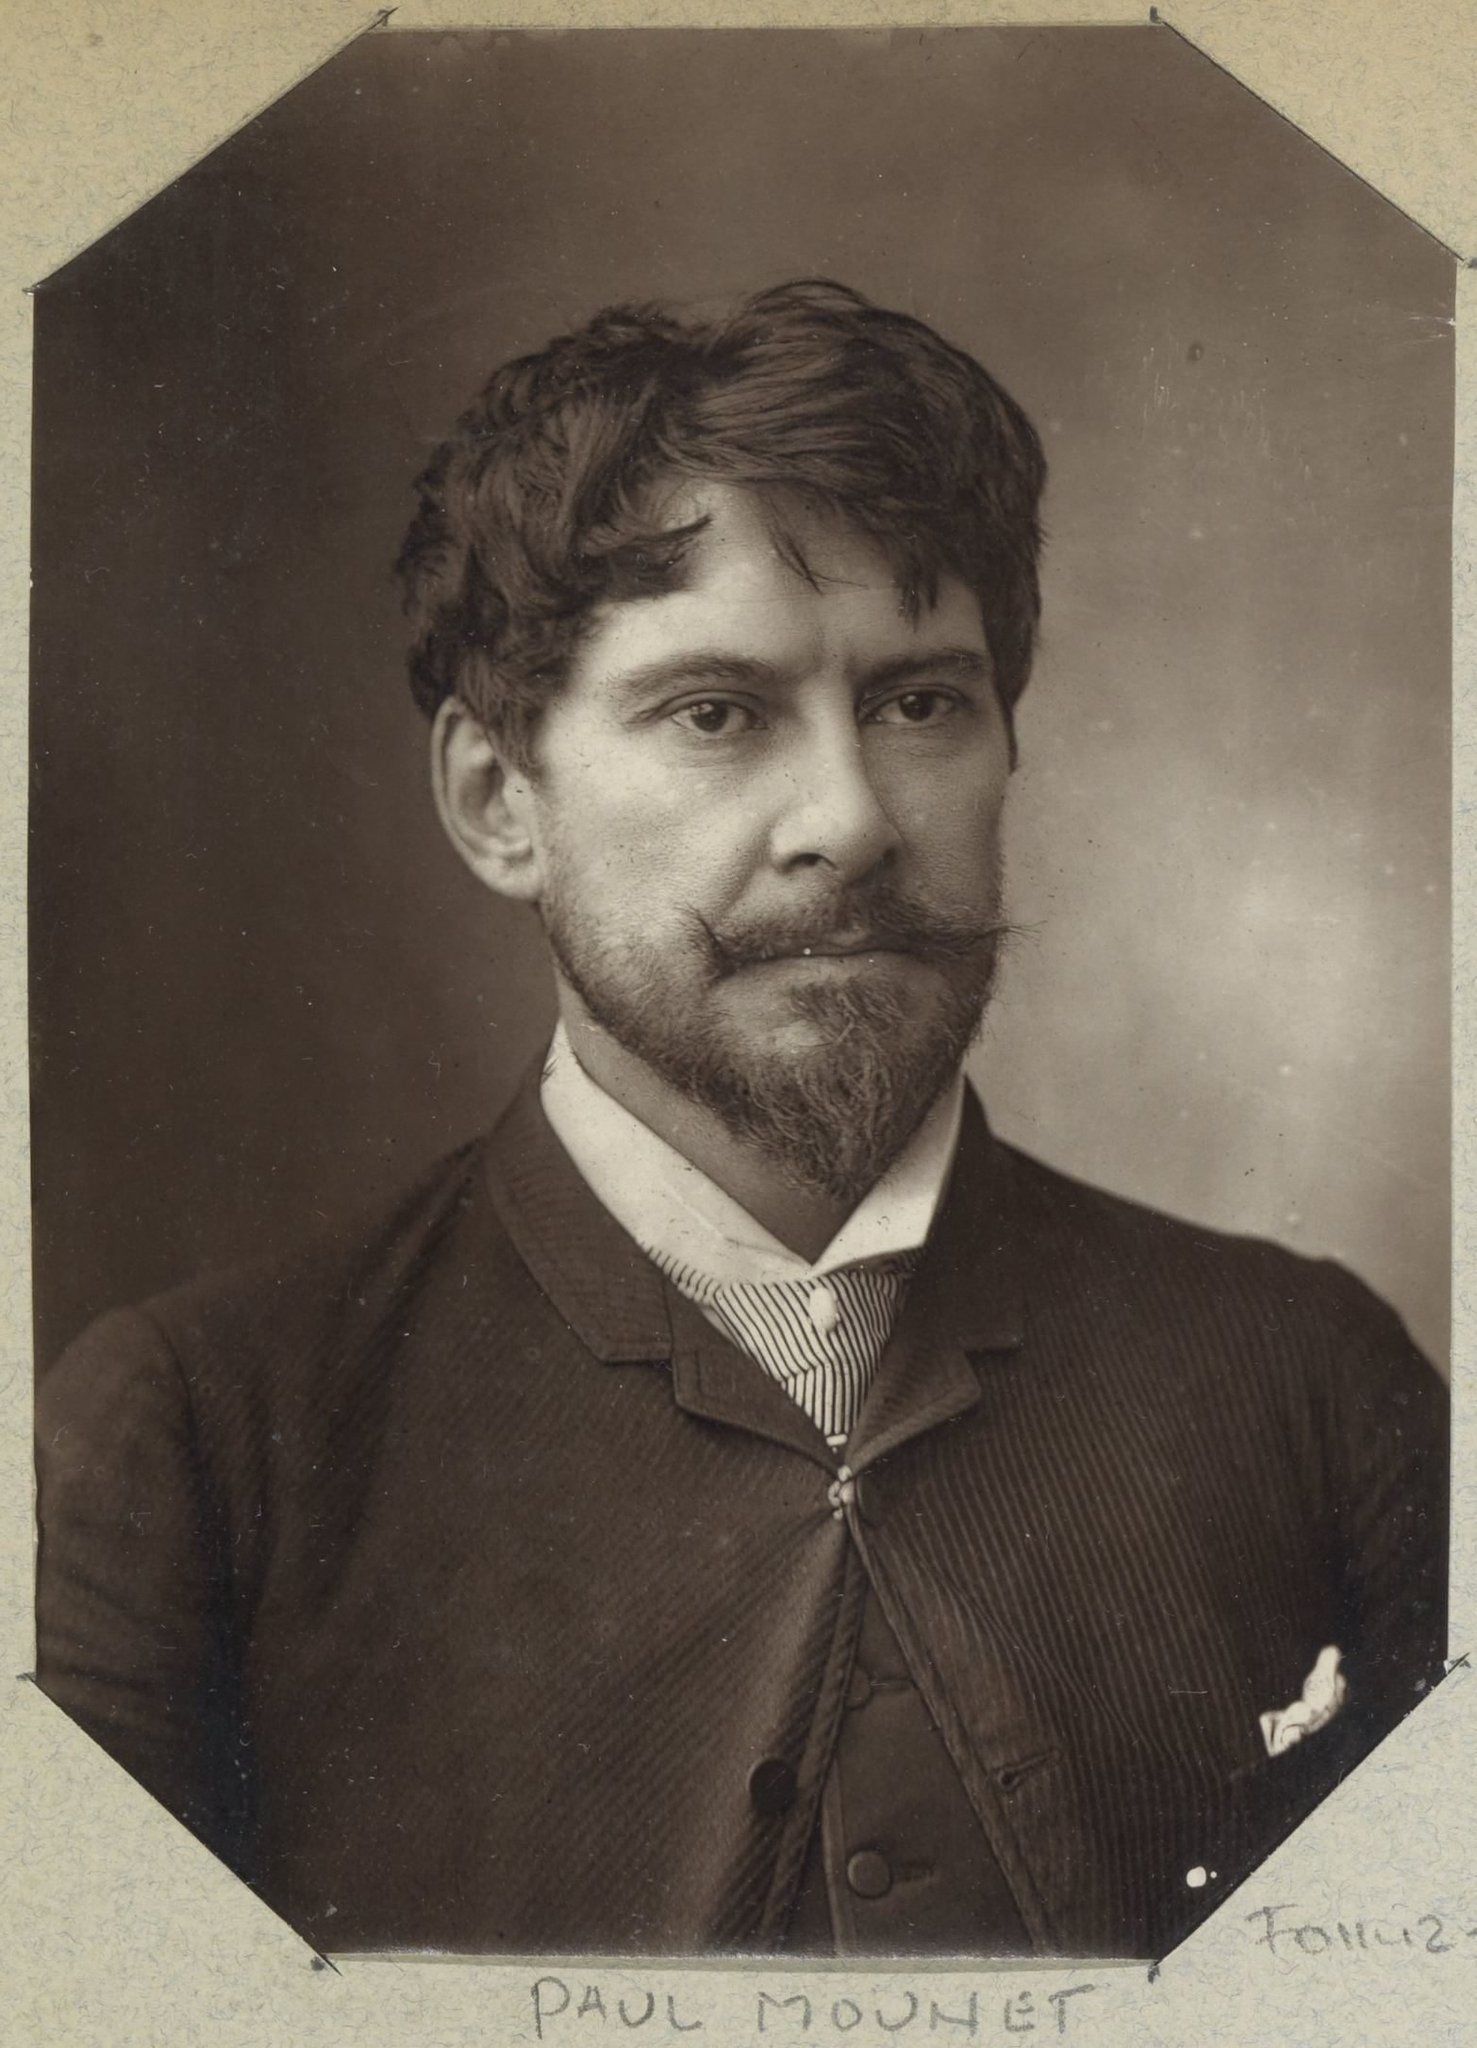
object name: photograph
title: Portret van Paul Mounet, Frans acteur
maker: Anonymous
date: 1880-1900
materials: paper, photographic support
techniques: carbon print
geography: france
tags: portrait of actor, actress, france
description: Onderdeel van Album van een Franse amateur met foto's van Frankrijk, Algerije, Palmyra, de Wereldtentoonstelling van 1900 en van bekende Fransen.